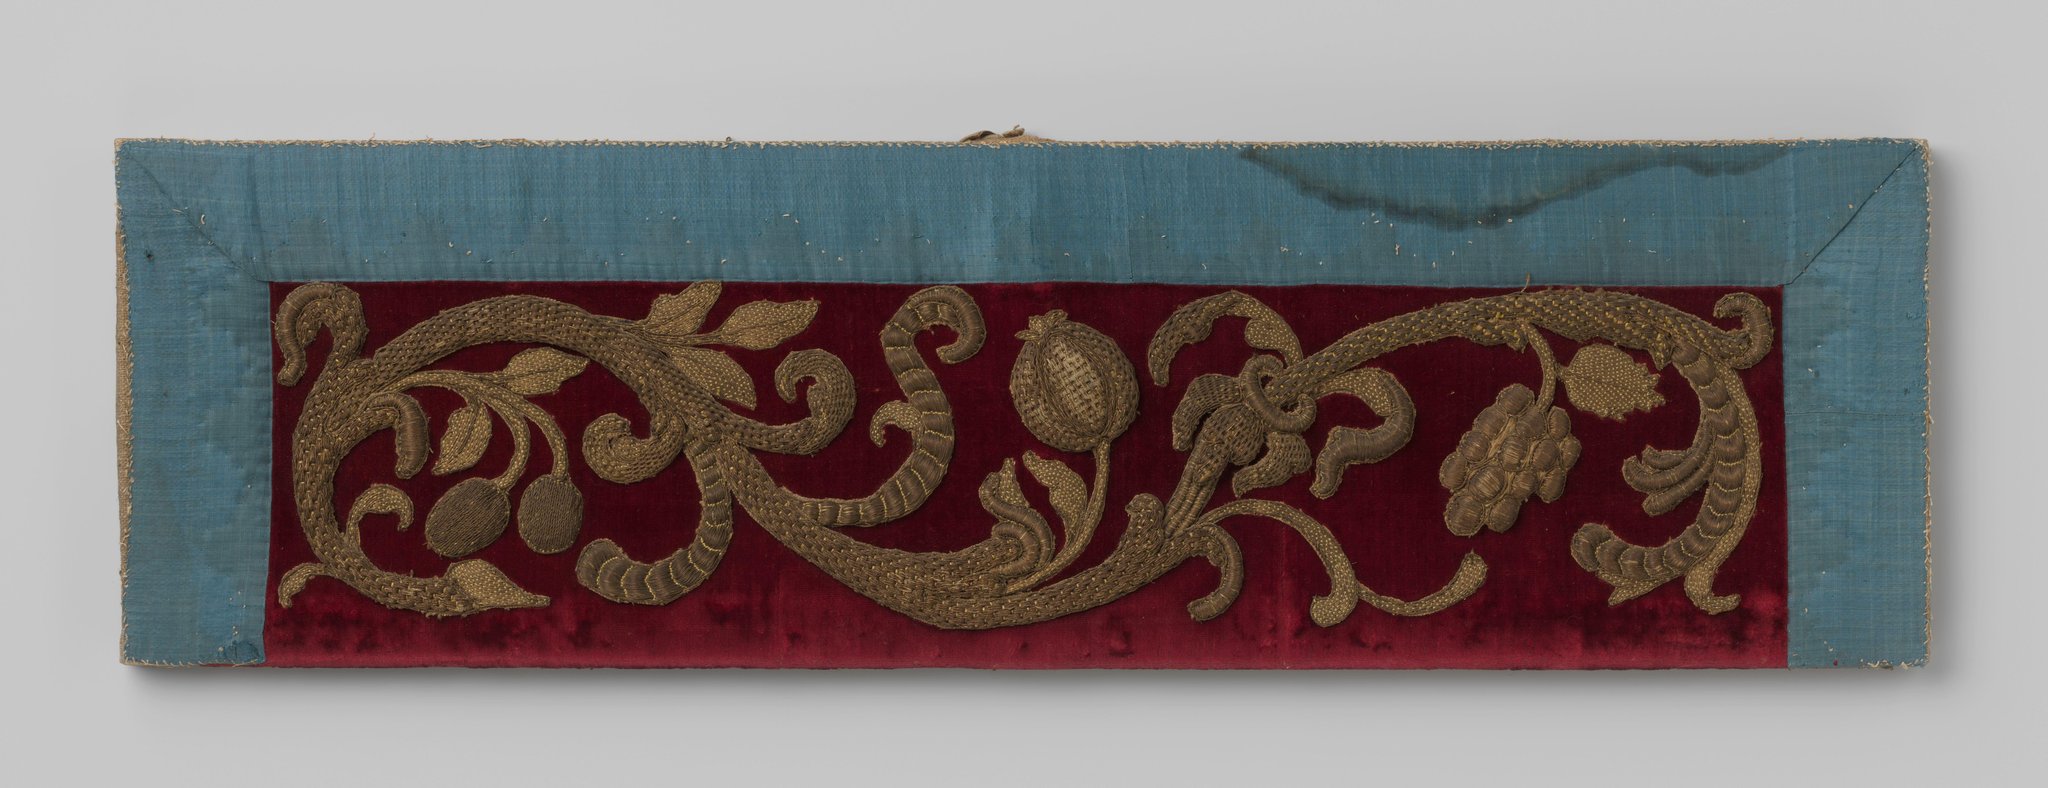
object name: strip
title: Strook met borduurwerk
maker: Anonymous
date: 1700-1725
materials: gold thread, silk, velvet, wood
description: Strook met gouden borduurwerk op karmozijnrode, fluwelen grond. Met rand van blauwe zijde. Op raam gezet.